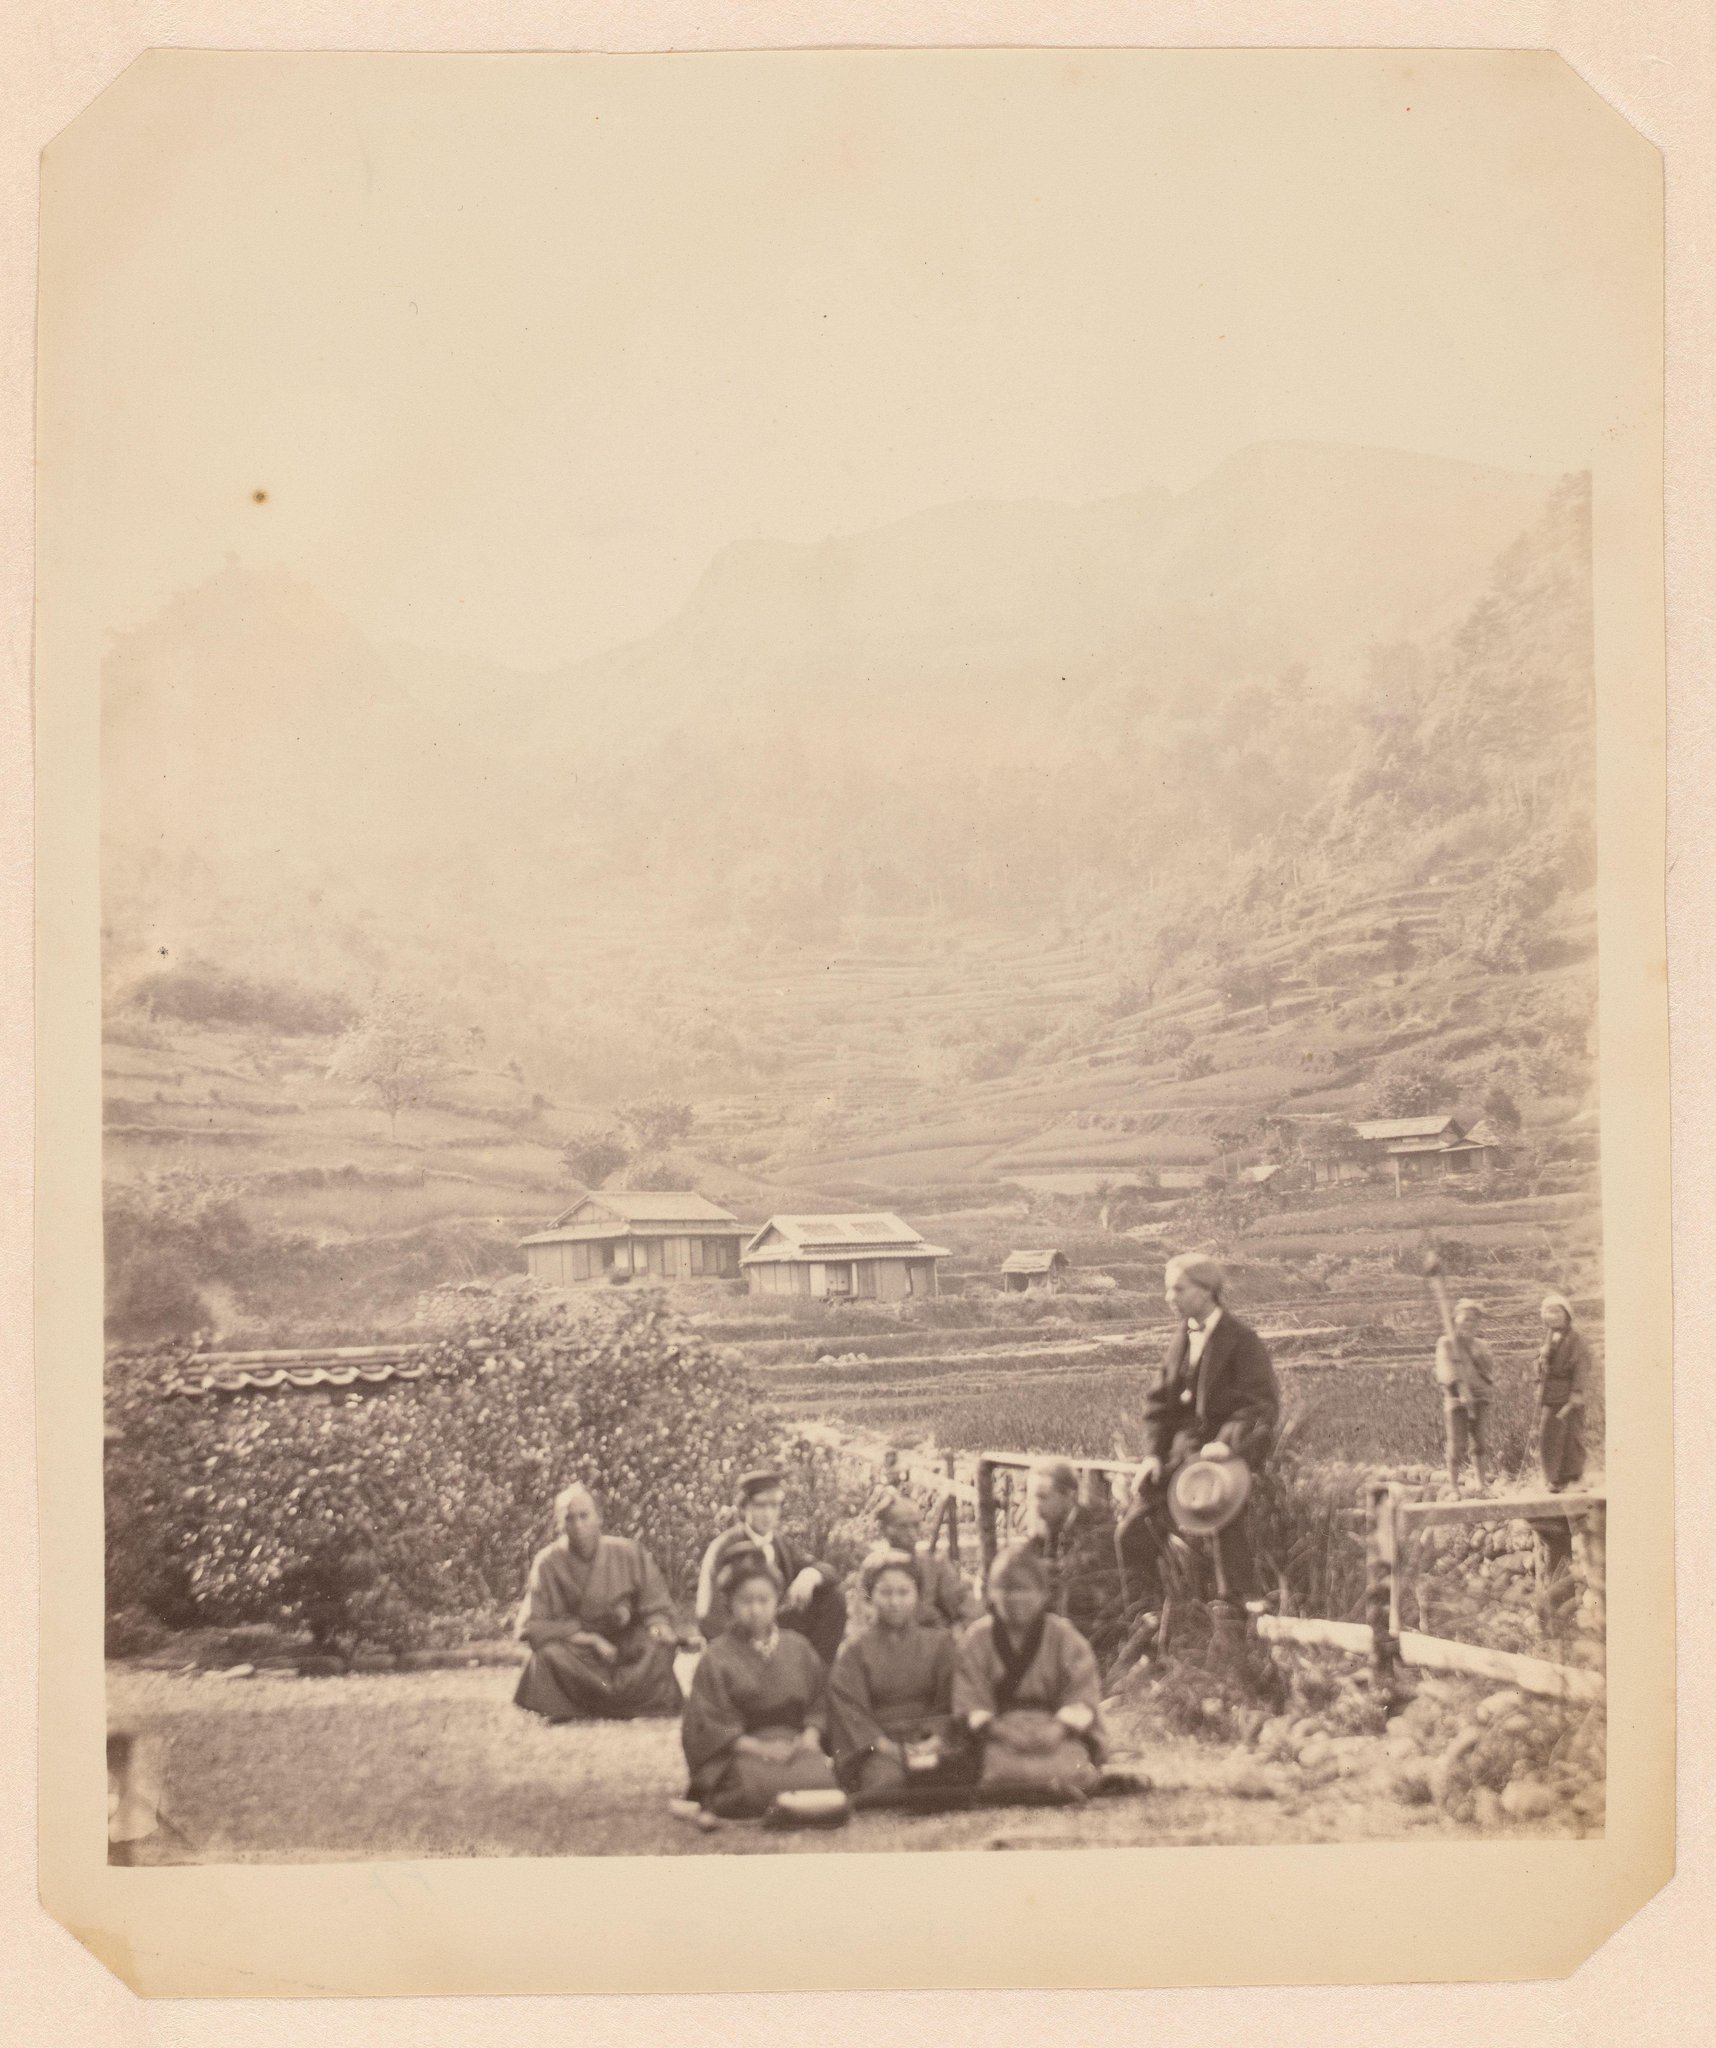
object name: photograph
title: Dorp met terrassen met groep mensen op de voorgrond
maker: antoon bauduin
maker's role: amateurfotograaf, hoogleraar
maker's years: 1820-1885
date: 1862-1866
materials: paper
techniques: albumen print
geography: japan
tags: prospect of village, silhouette of village, japan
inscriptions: number: ‘BD109’, number: ‘F7.’